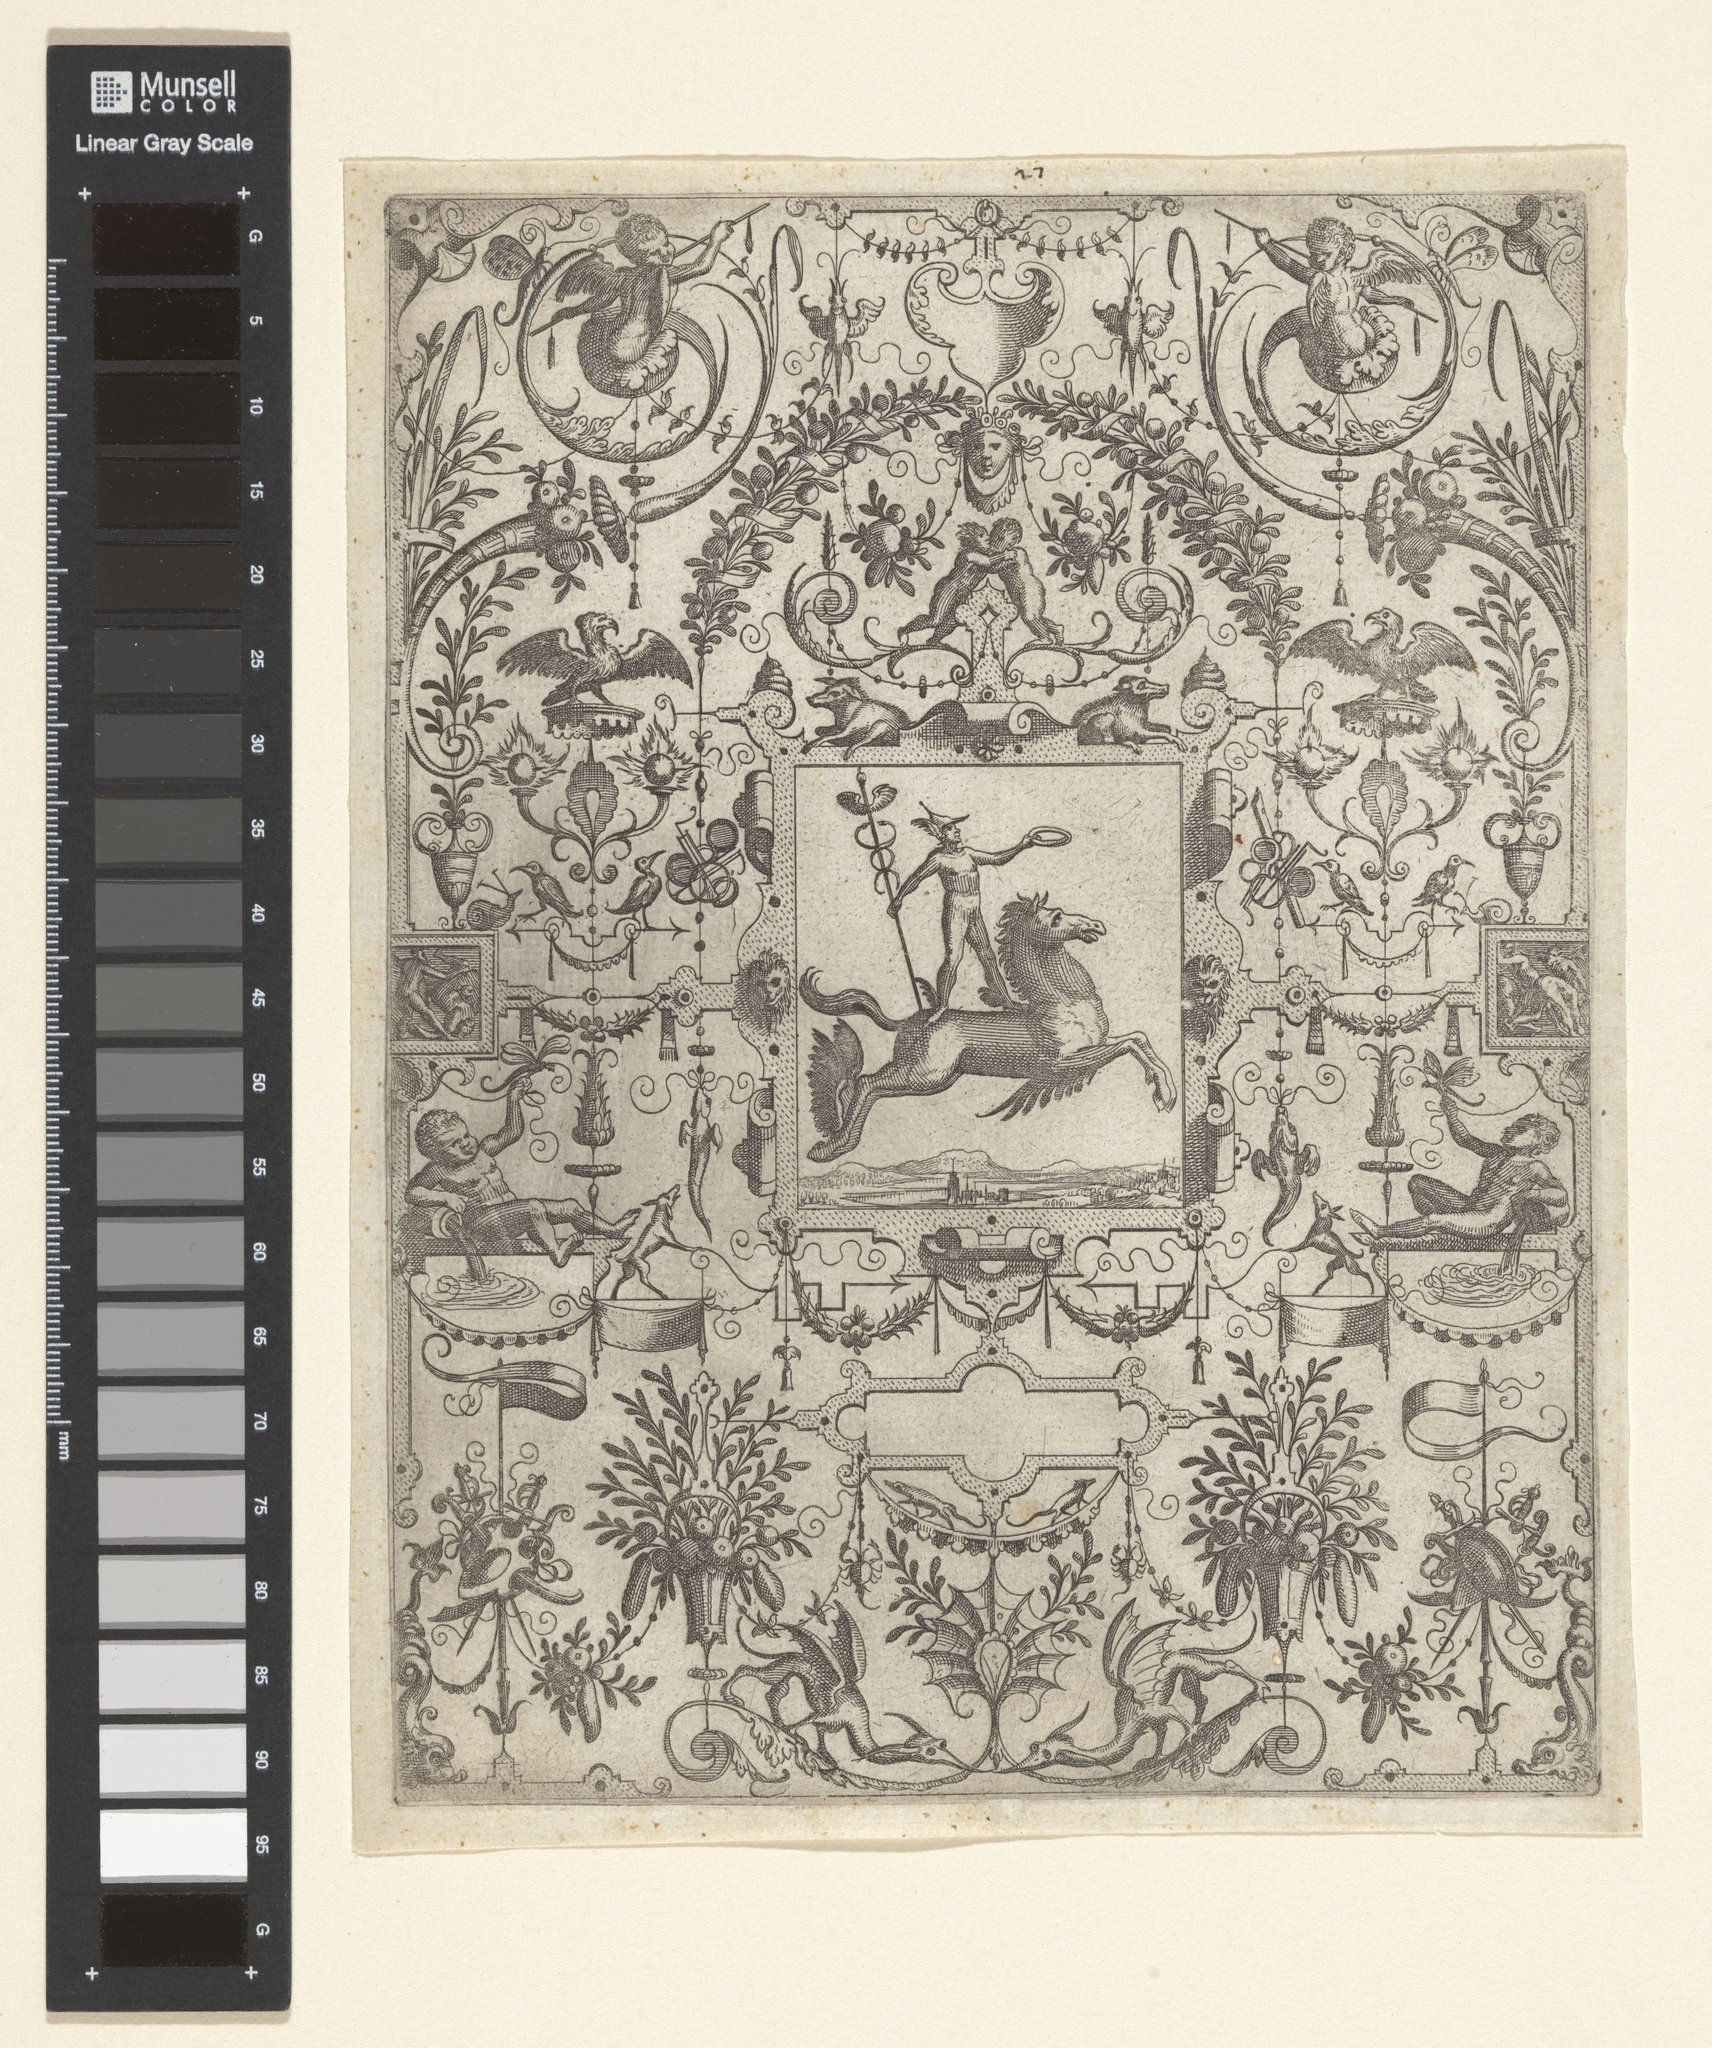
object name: print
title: Vijf bladen uit de reeks: Grottesco in diversche manieren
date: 1565-1571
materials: paper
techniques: etching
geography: netherlands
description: Op de bladranken boven de cartouche staan twee elkaar omhelzende kinderen, elk met een zwijn onder zijn voeten. Uit serie van titelblad + 16 bladen met cartouches of architectuurfantasieën met een voorstelling in een omlijsting van grotesken met fabelwezens, dieren, guirlandes, trofeeën en mascarons.